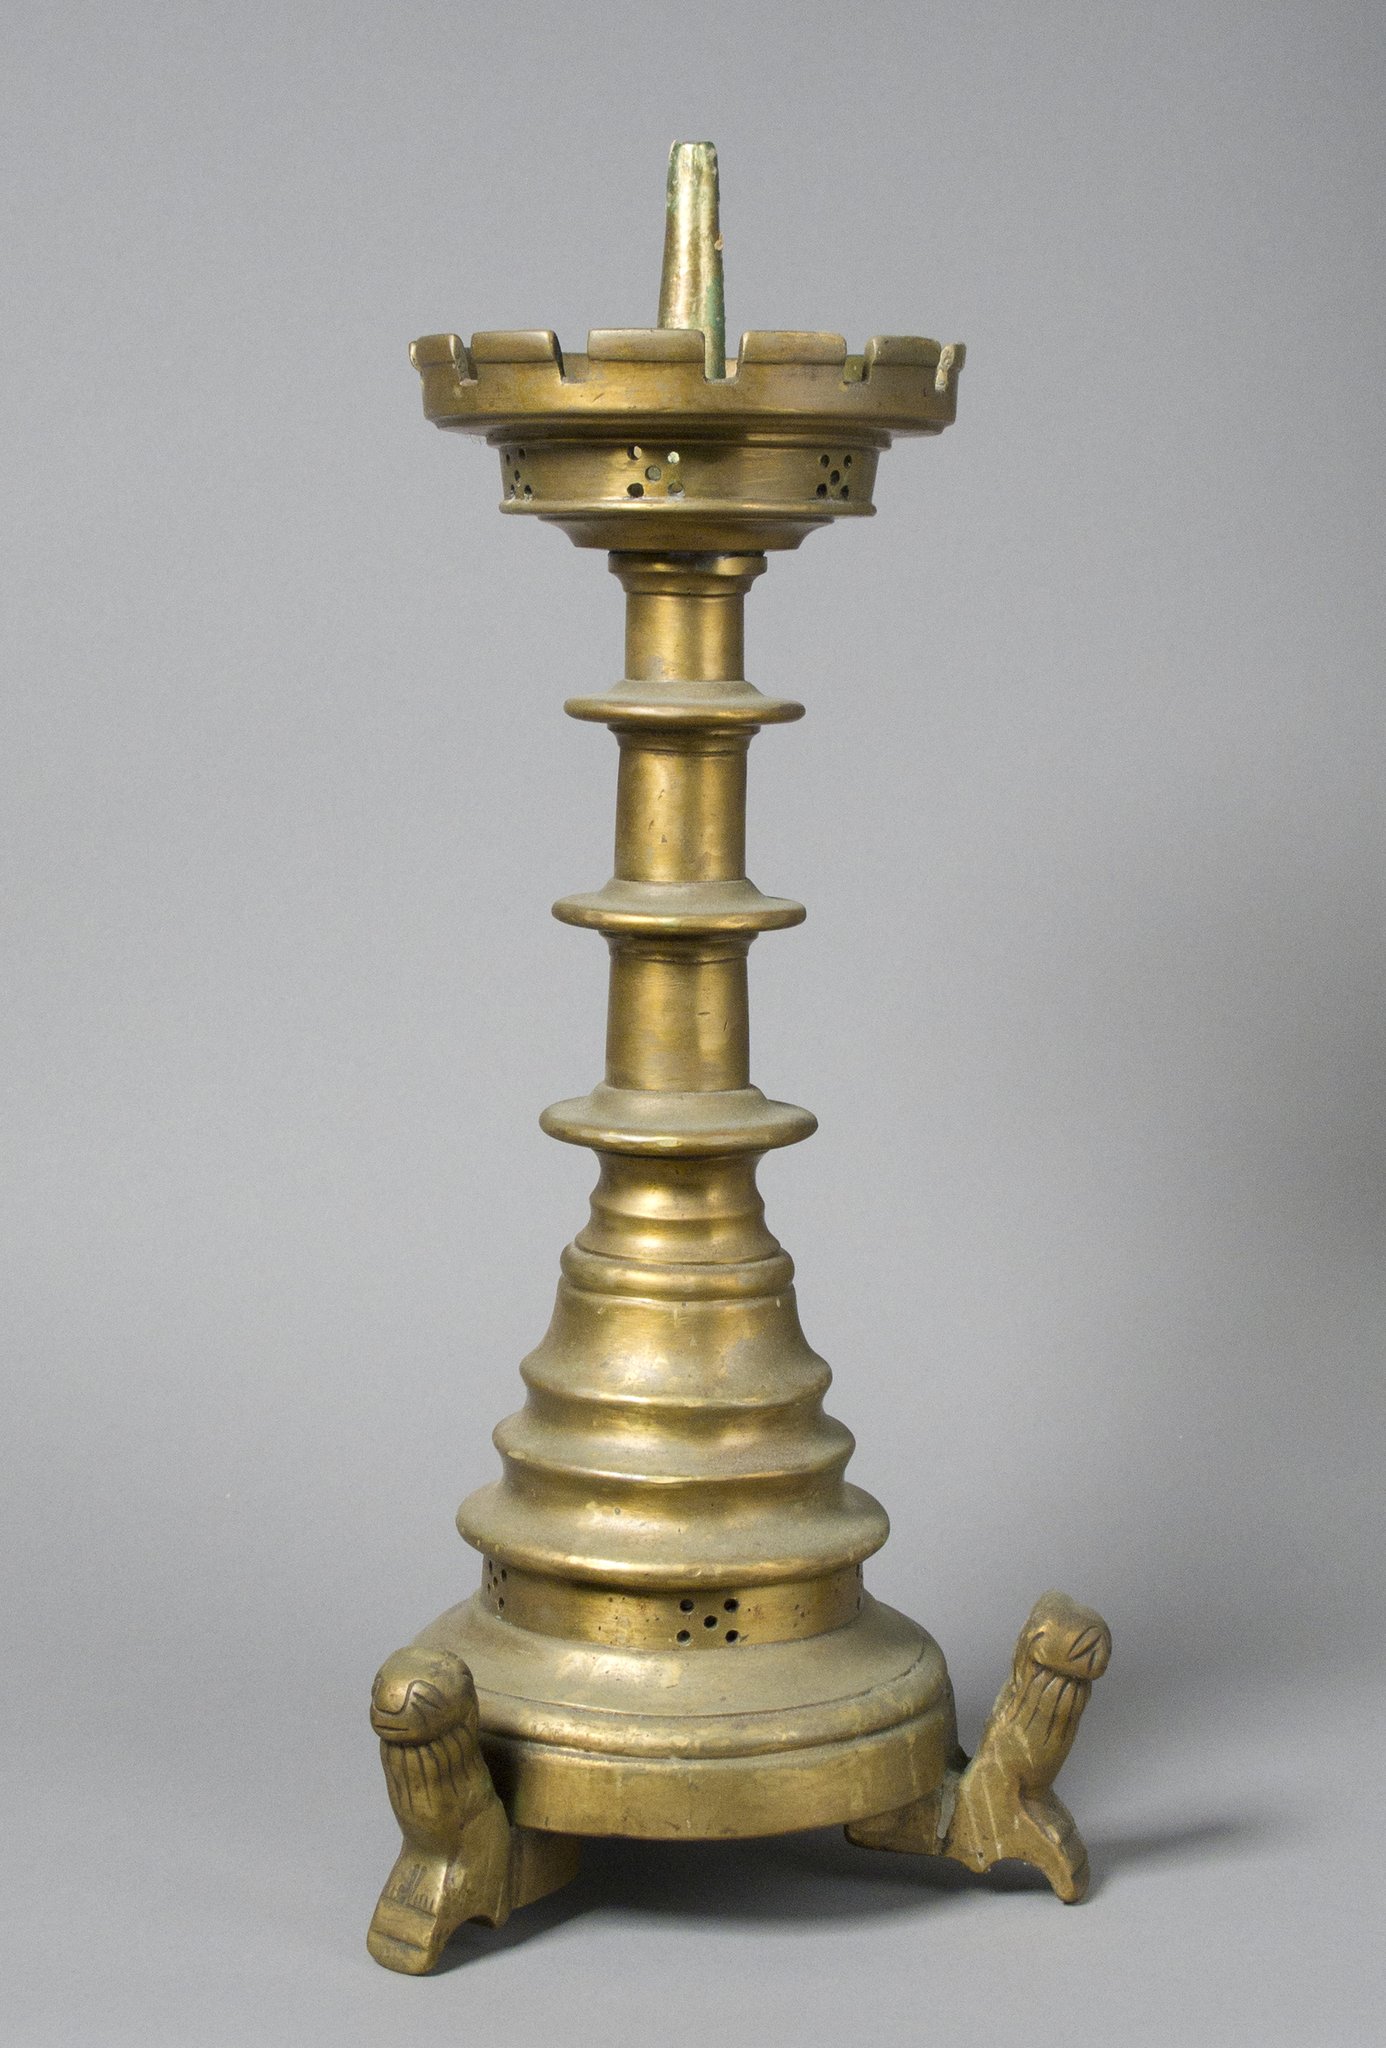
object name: candlestick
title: Candlestick, Pricket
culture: south netherlandish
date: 1401-1500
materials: brass